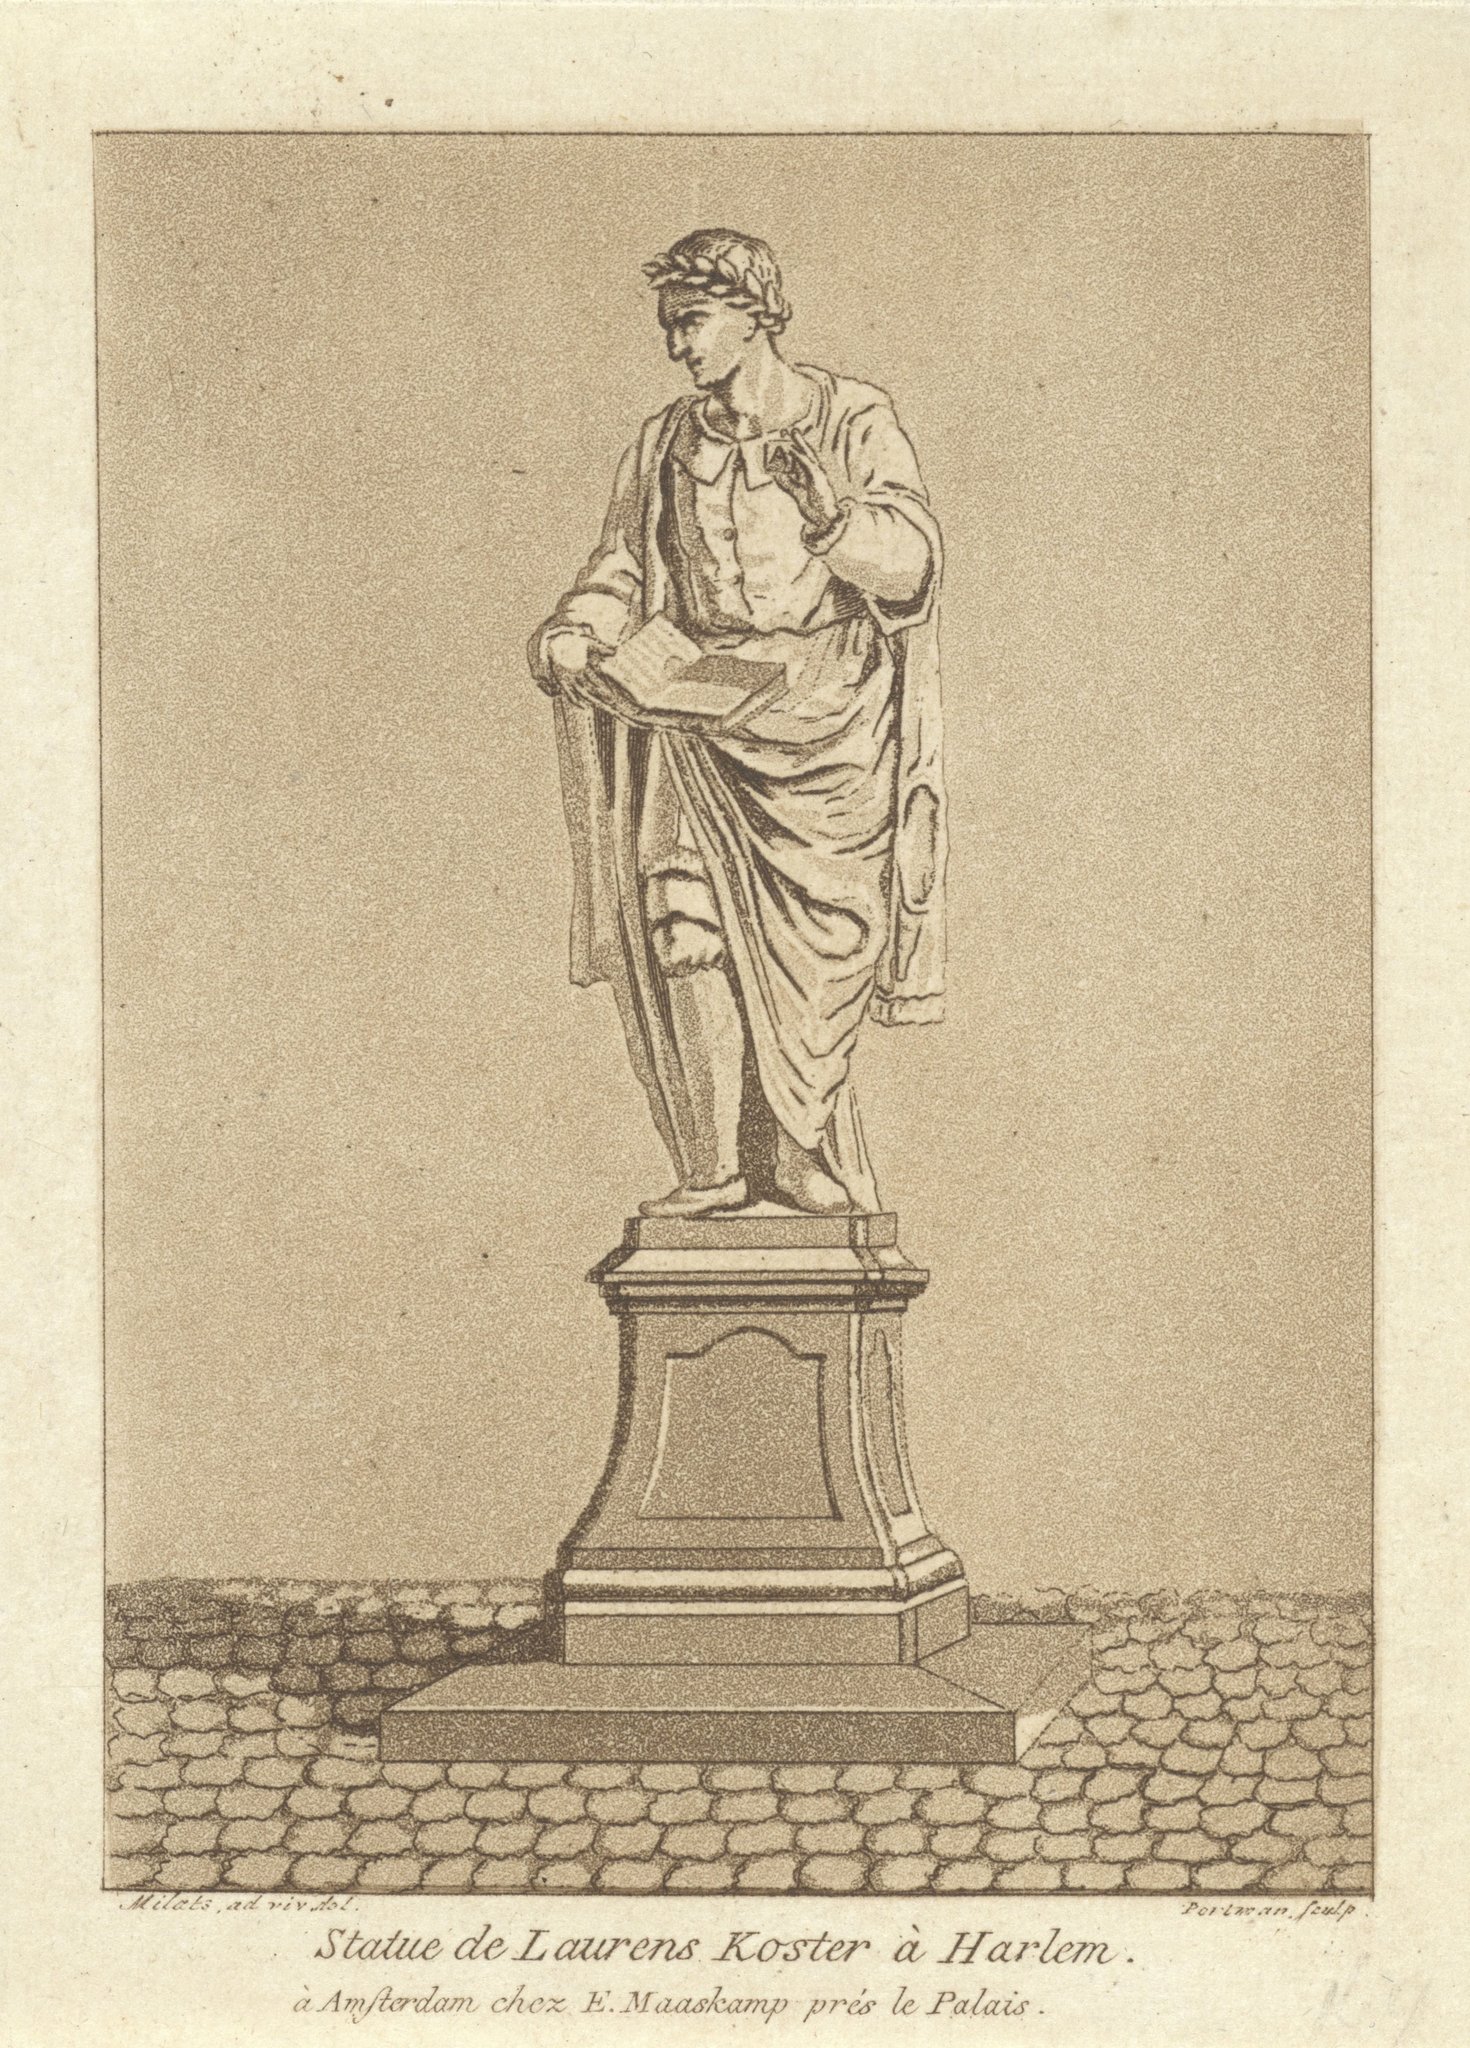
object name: print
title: Statue de Laurens Koster à Harlem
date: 1794-1828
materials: paper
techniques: aquatint, etching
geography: amsterdam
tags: piece of sculpture, reproduction of a piece of sculpture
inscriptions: collector's mark: Lugt 2228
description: Laurens Jansz. Coster, ten voeten uit, met een boek en een drukletter in de handen. Standbeeld in de hortus van het Stedelijk Gymnasium te Haarlem. Het standbeeld is in 1722 vervaardigd door Gerrit van Heerstal naar een ontwerp van Romeyn de Hooghe.